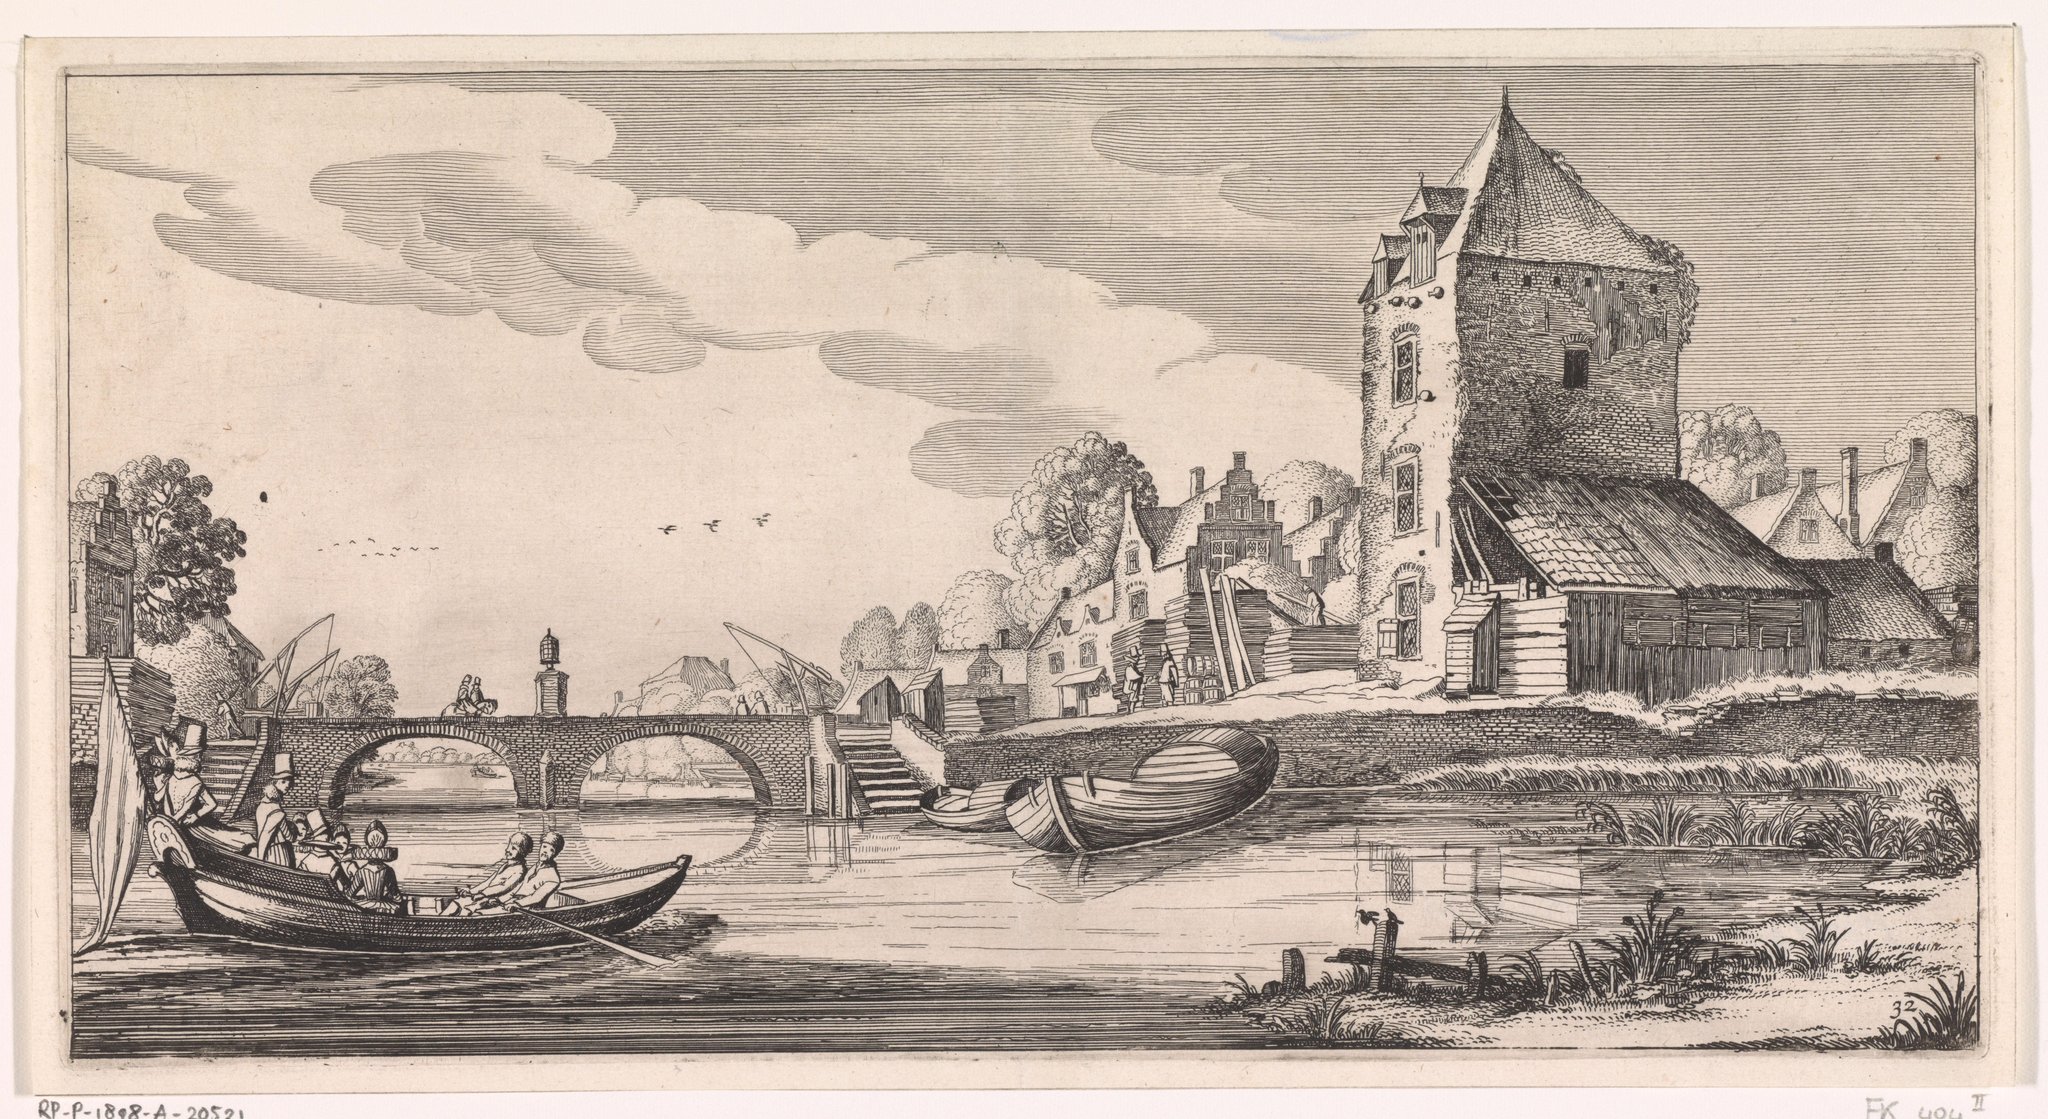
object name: print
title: Dorp aan een rivier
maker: jan van de velde (ii)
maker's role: draughtsman, painter, print maker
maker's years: 1593-1641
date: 1639-1641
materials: paper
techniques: etching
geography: northern netherlands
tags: city-view in general; 'veduta', river, rowing-boat, canoe, etc., landscape with tower or castle, canals, waters (in city), bridge in city across river, canal, etc.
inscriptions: collector's mark: Lugt 964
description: Boten op het water bij een dorp aan een rivier. Tussen twee oevers een stenen brug. Links wordt een elegant gezelschap in een boot voort geroeid door twee figuren. 32ste prent van een serie met 36 prenten van landschappen, verdeeld over zes delen.